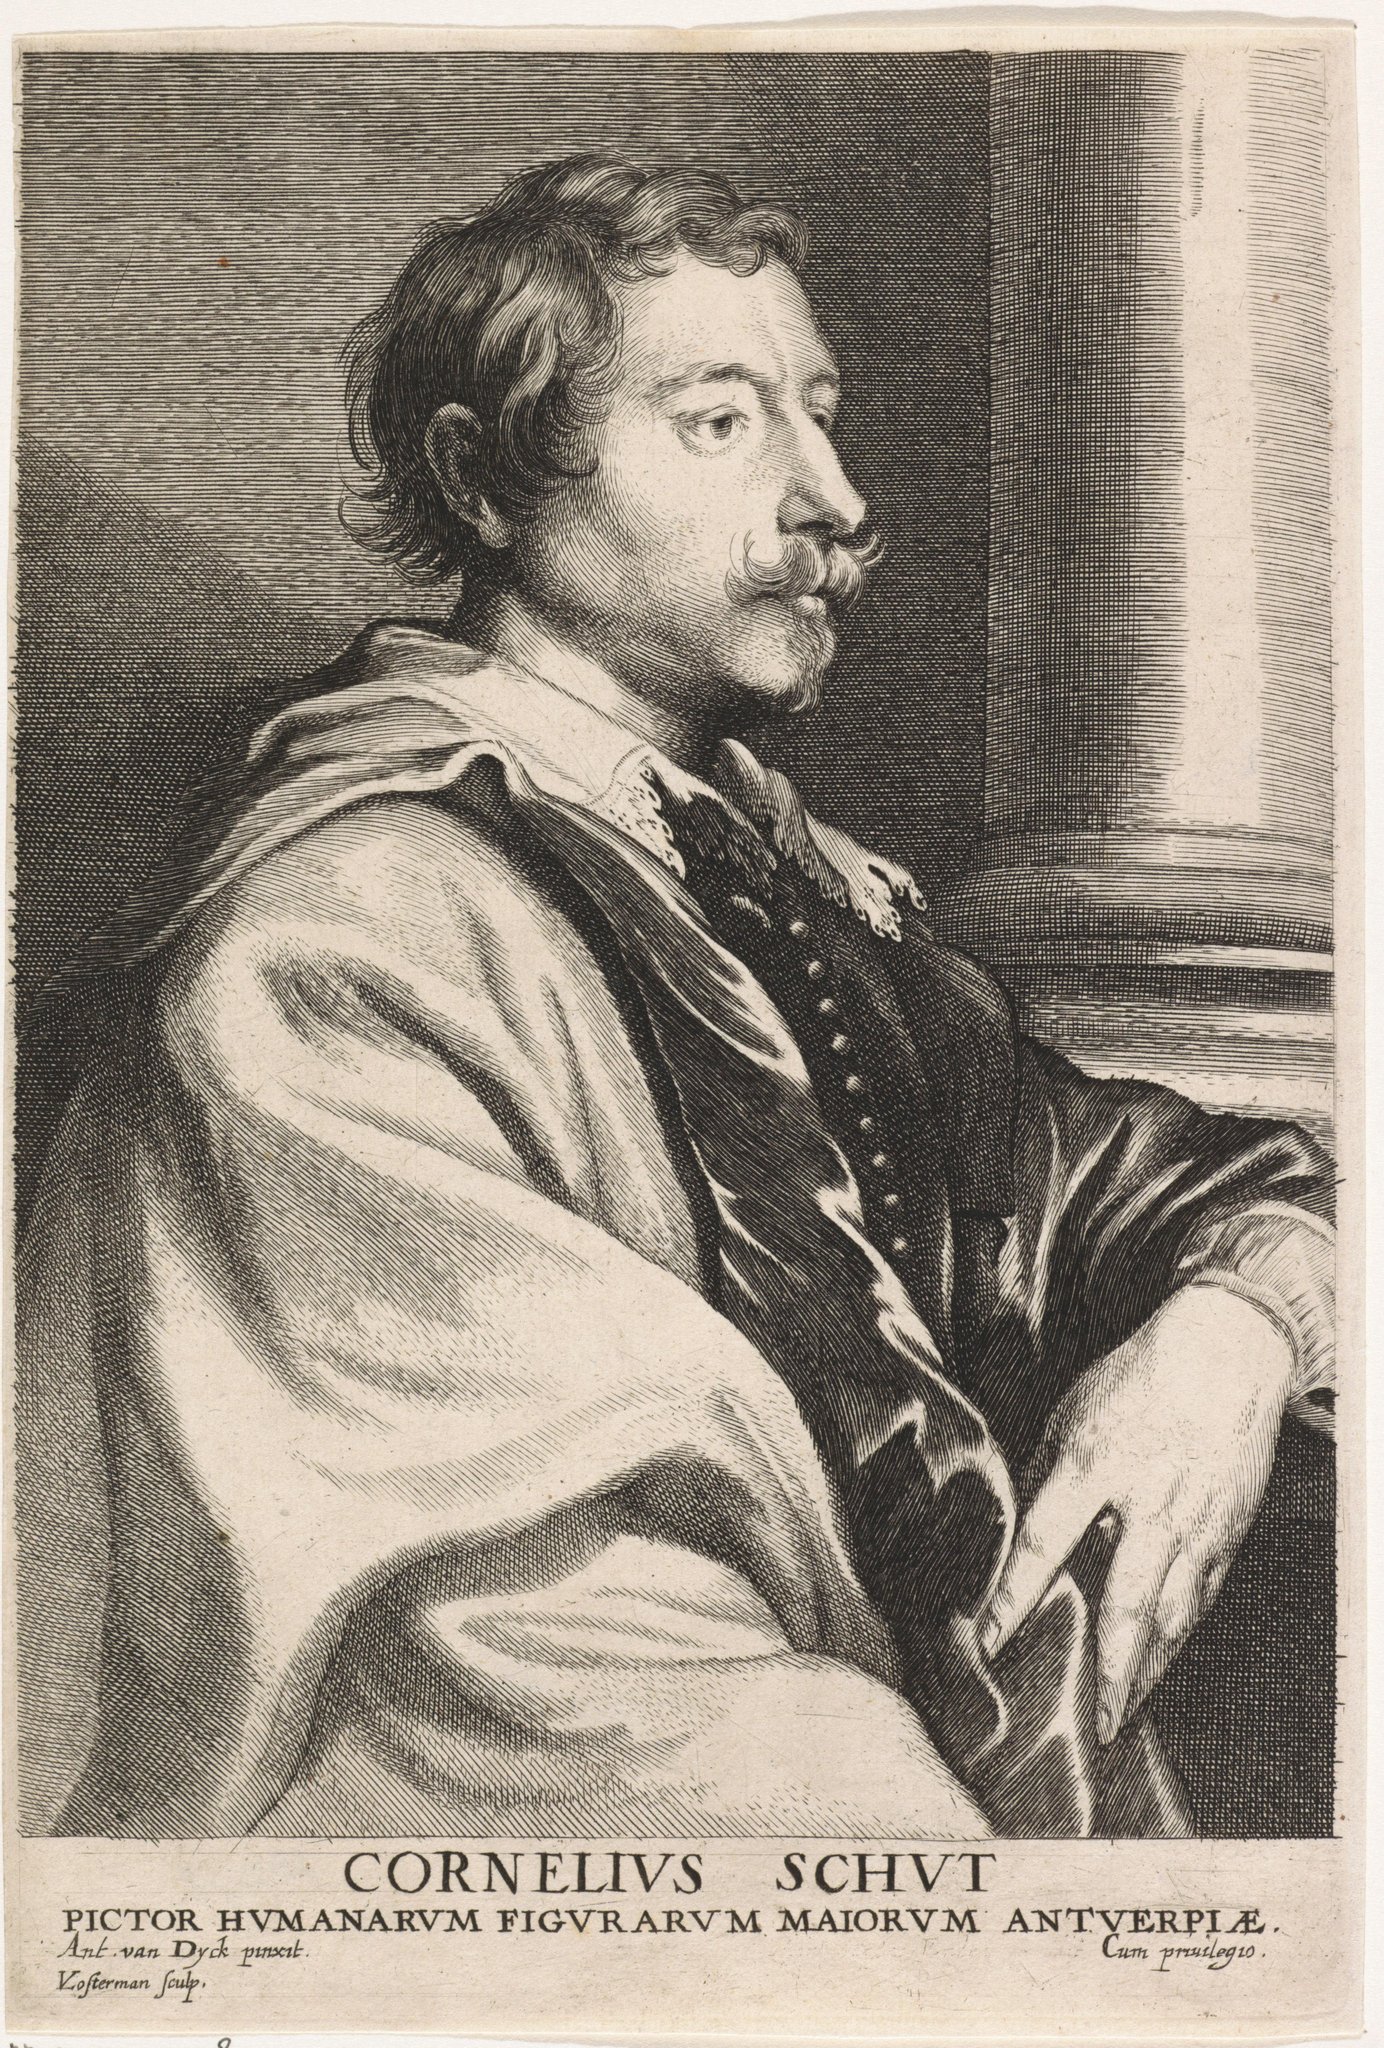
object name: print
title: Iconographie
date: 1646-1675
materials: paper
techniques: engraving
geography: antwerp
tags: antwerp, print maker, draughtsman, cornelis schut (i)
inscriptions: collector's mark: Lugt 240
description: Prent gebruikt voor: Icones principum, virorum doctorum, pictorum, chalcographorum, statuariorum nec non amatorum pictoriae artis numero centum ab Ant. van Dyck ad vivum expressae ejusque sumptibus aeri incisae. Antwerpen: Gillis Hendricx, [1645-1646].